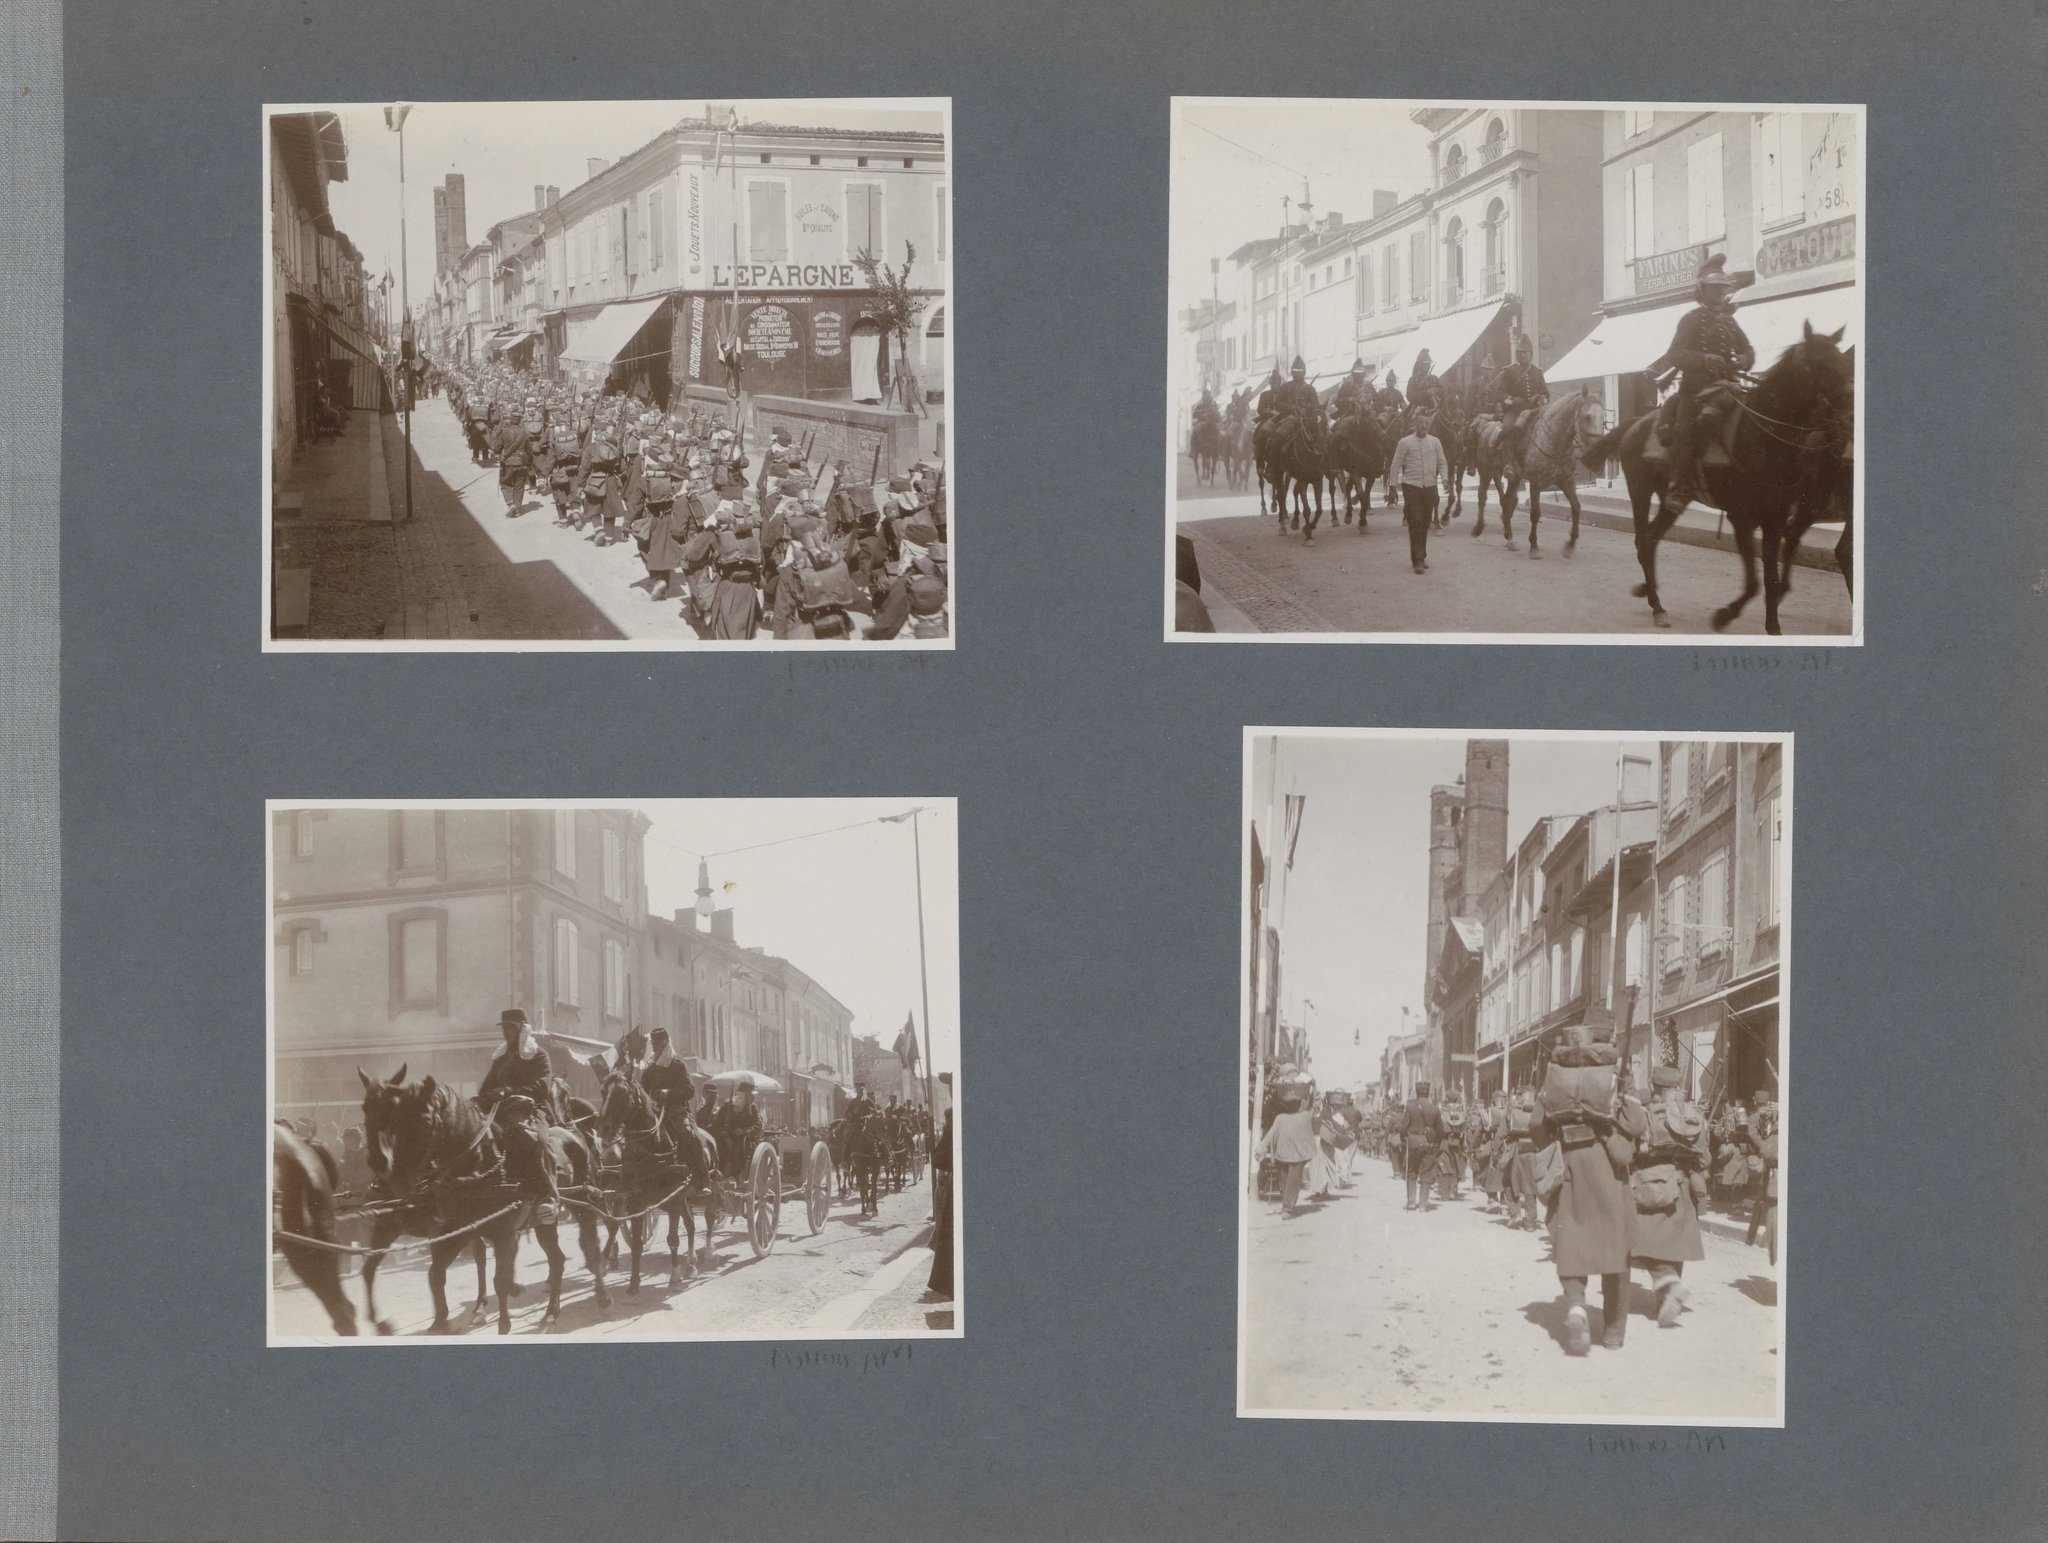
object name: album leaf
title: Intocht van militairen, mogelijk in Toulouse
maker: Anonymous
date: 1902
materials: paper, photographic support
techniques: daylight paper print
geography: toulouse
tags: shop, store, marching away (troops), land forces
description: Onderdeel van Fotoalbum van een legeroefening in Zuidwest-Frankrijk in 1902.